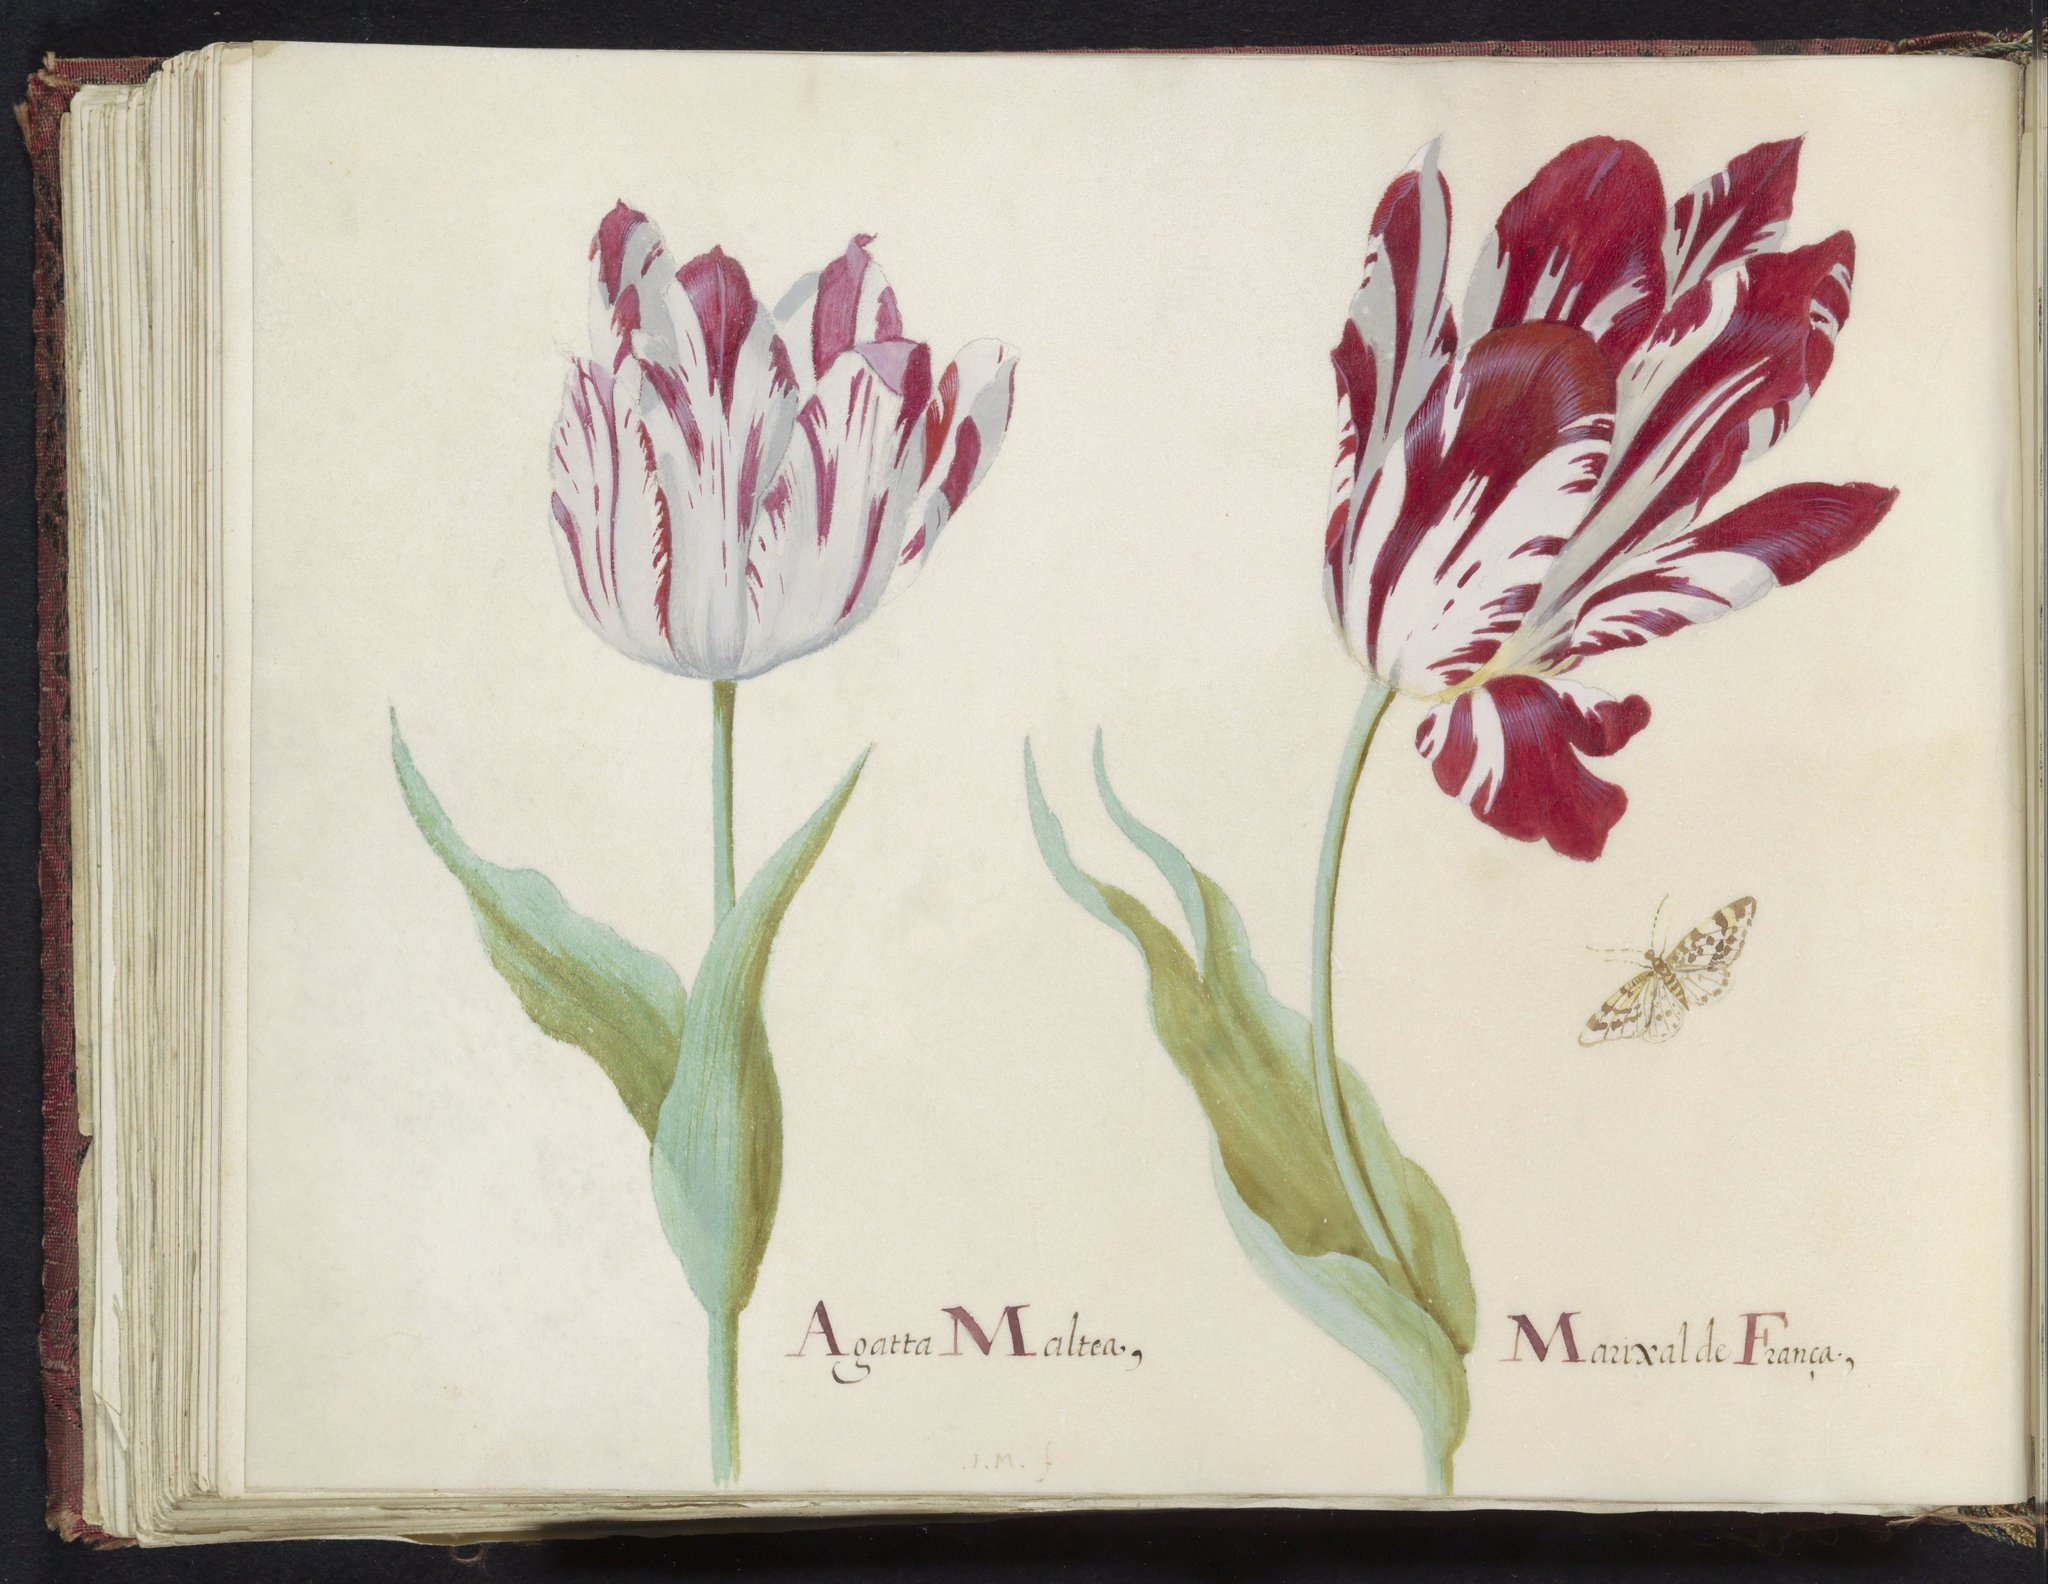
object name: album leaf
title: Twee tulpen met vlinder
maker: jacob marrel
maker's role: draughtsman, painter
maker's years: 1614-1681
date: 1637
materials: paint, parchment, pencil, watercolor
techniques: brush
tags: insects: butterfly, flowers: tulip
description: De tekening maakt deel uit van een album.